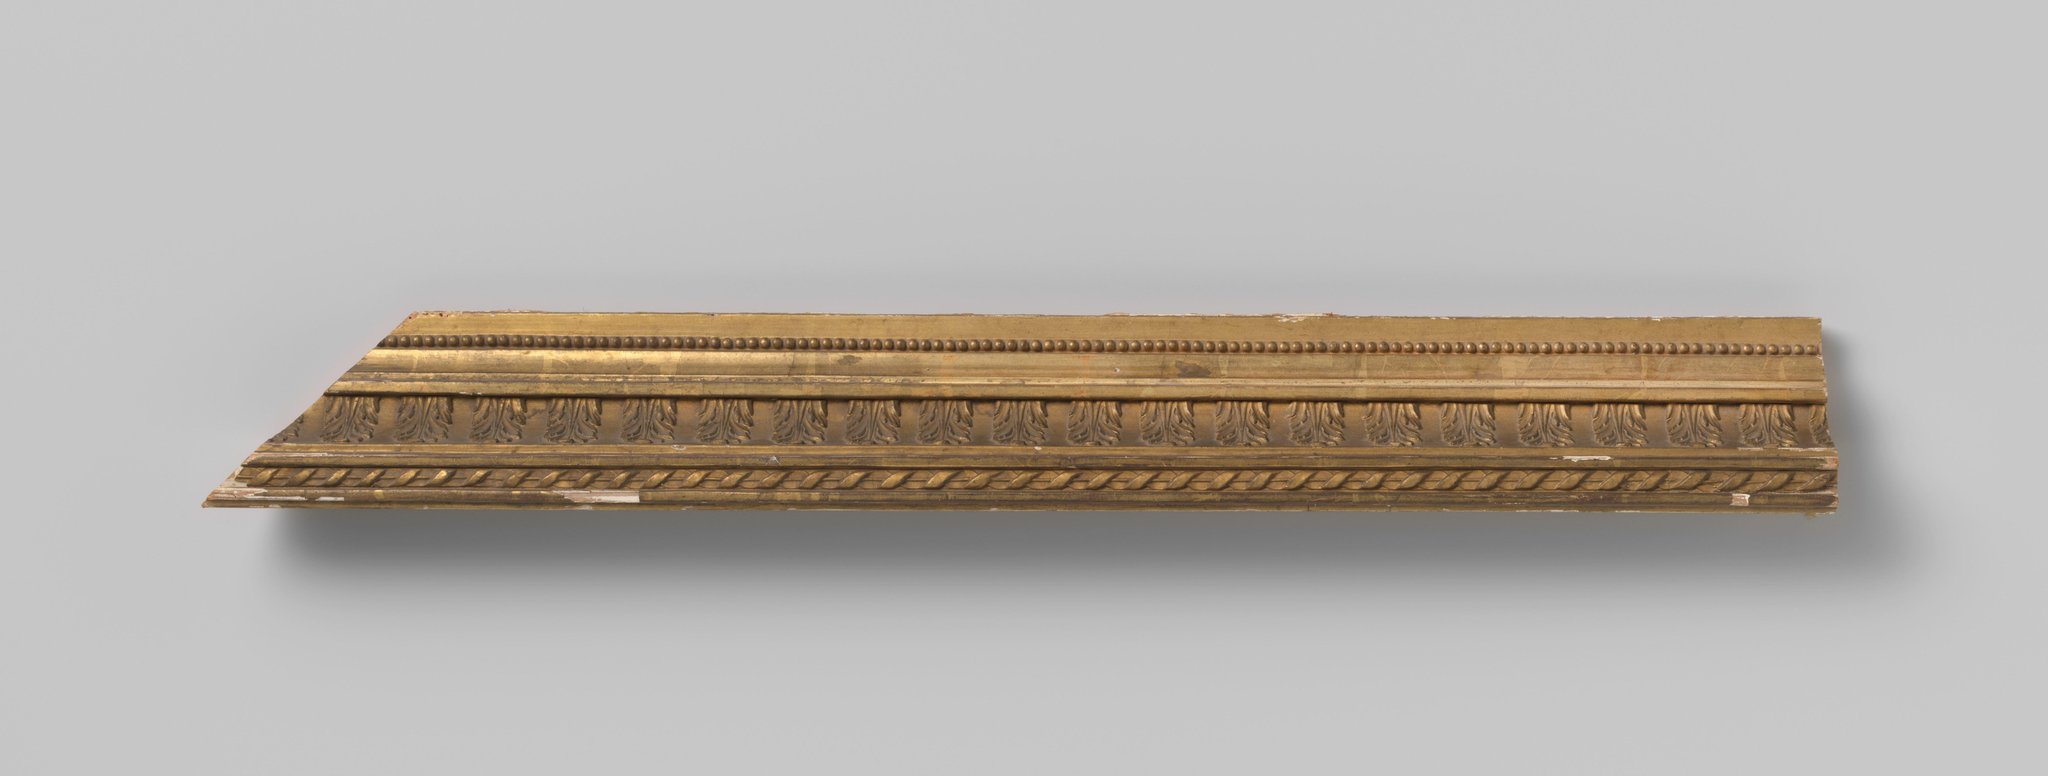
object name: frame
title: Lijstfragment van vergulde lijst met pâte-ornamenten in Empire stijl: stijl.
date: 1500-1999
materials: gold leaf, wood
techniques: gilding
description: Stijl van een schilderijlijst van hout versierd met pâte-ornamenten en voorzien van (poliment)vergulding.